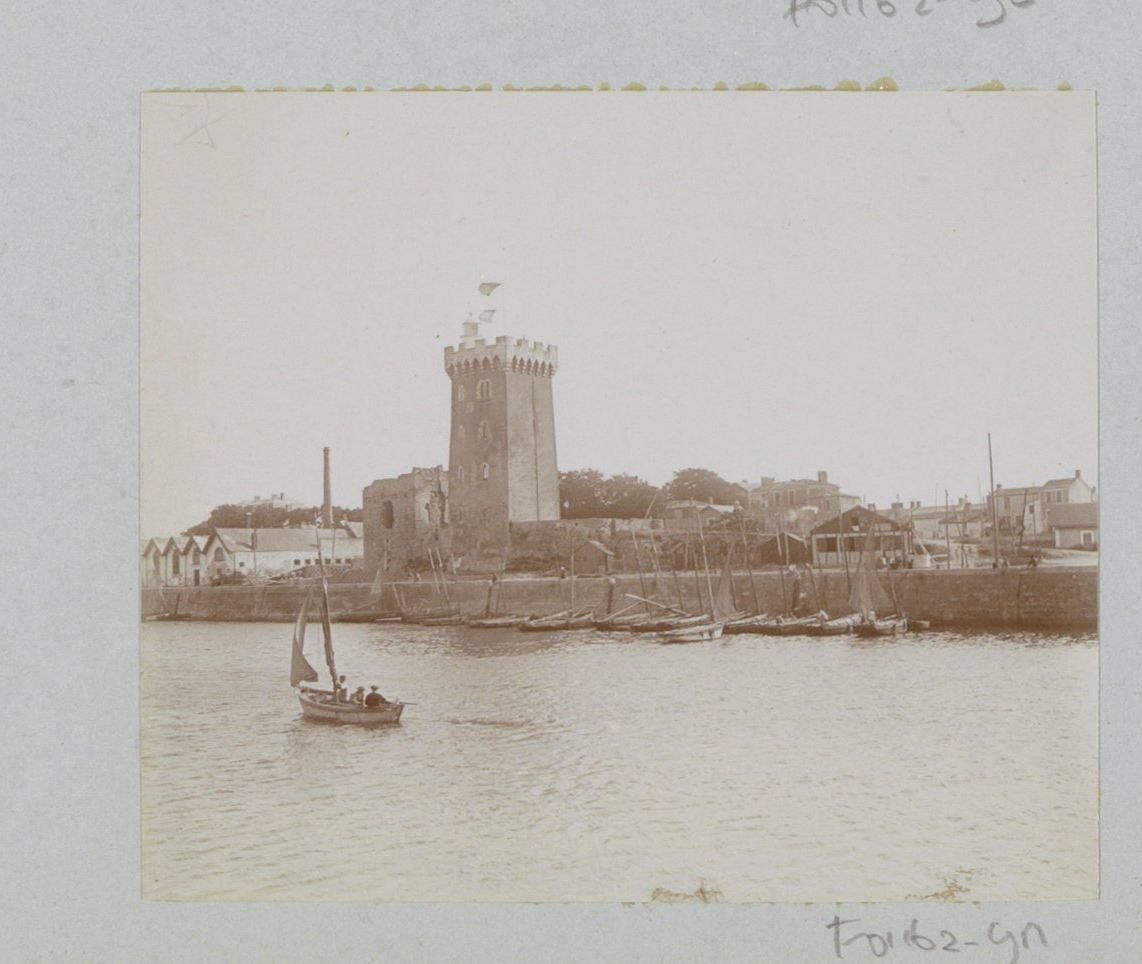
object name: photograph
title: Gezicht op een toren aan een kade in Frankrijk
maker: Anonymous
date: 1905-1910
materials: paper, photographic support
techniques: gelatin silver print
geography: france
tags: towers ~ fortified city, quay (+ city(-scape) with figures, staffage), france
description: Onderdeel van Fotoalbum van een Franse amateurfotograaf met bezienswaardigheden in Frankrijk, Zwitserland en Italië.